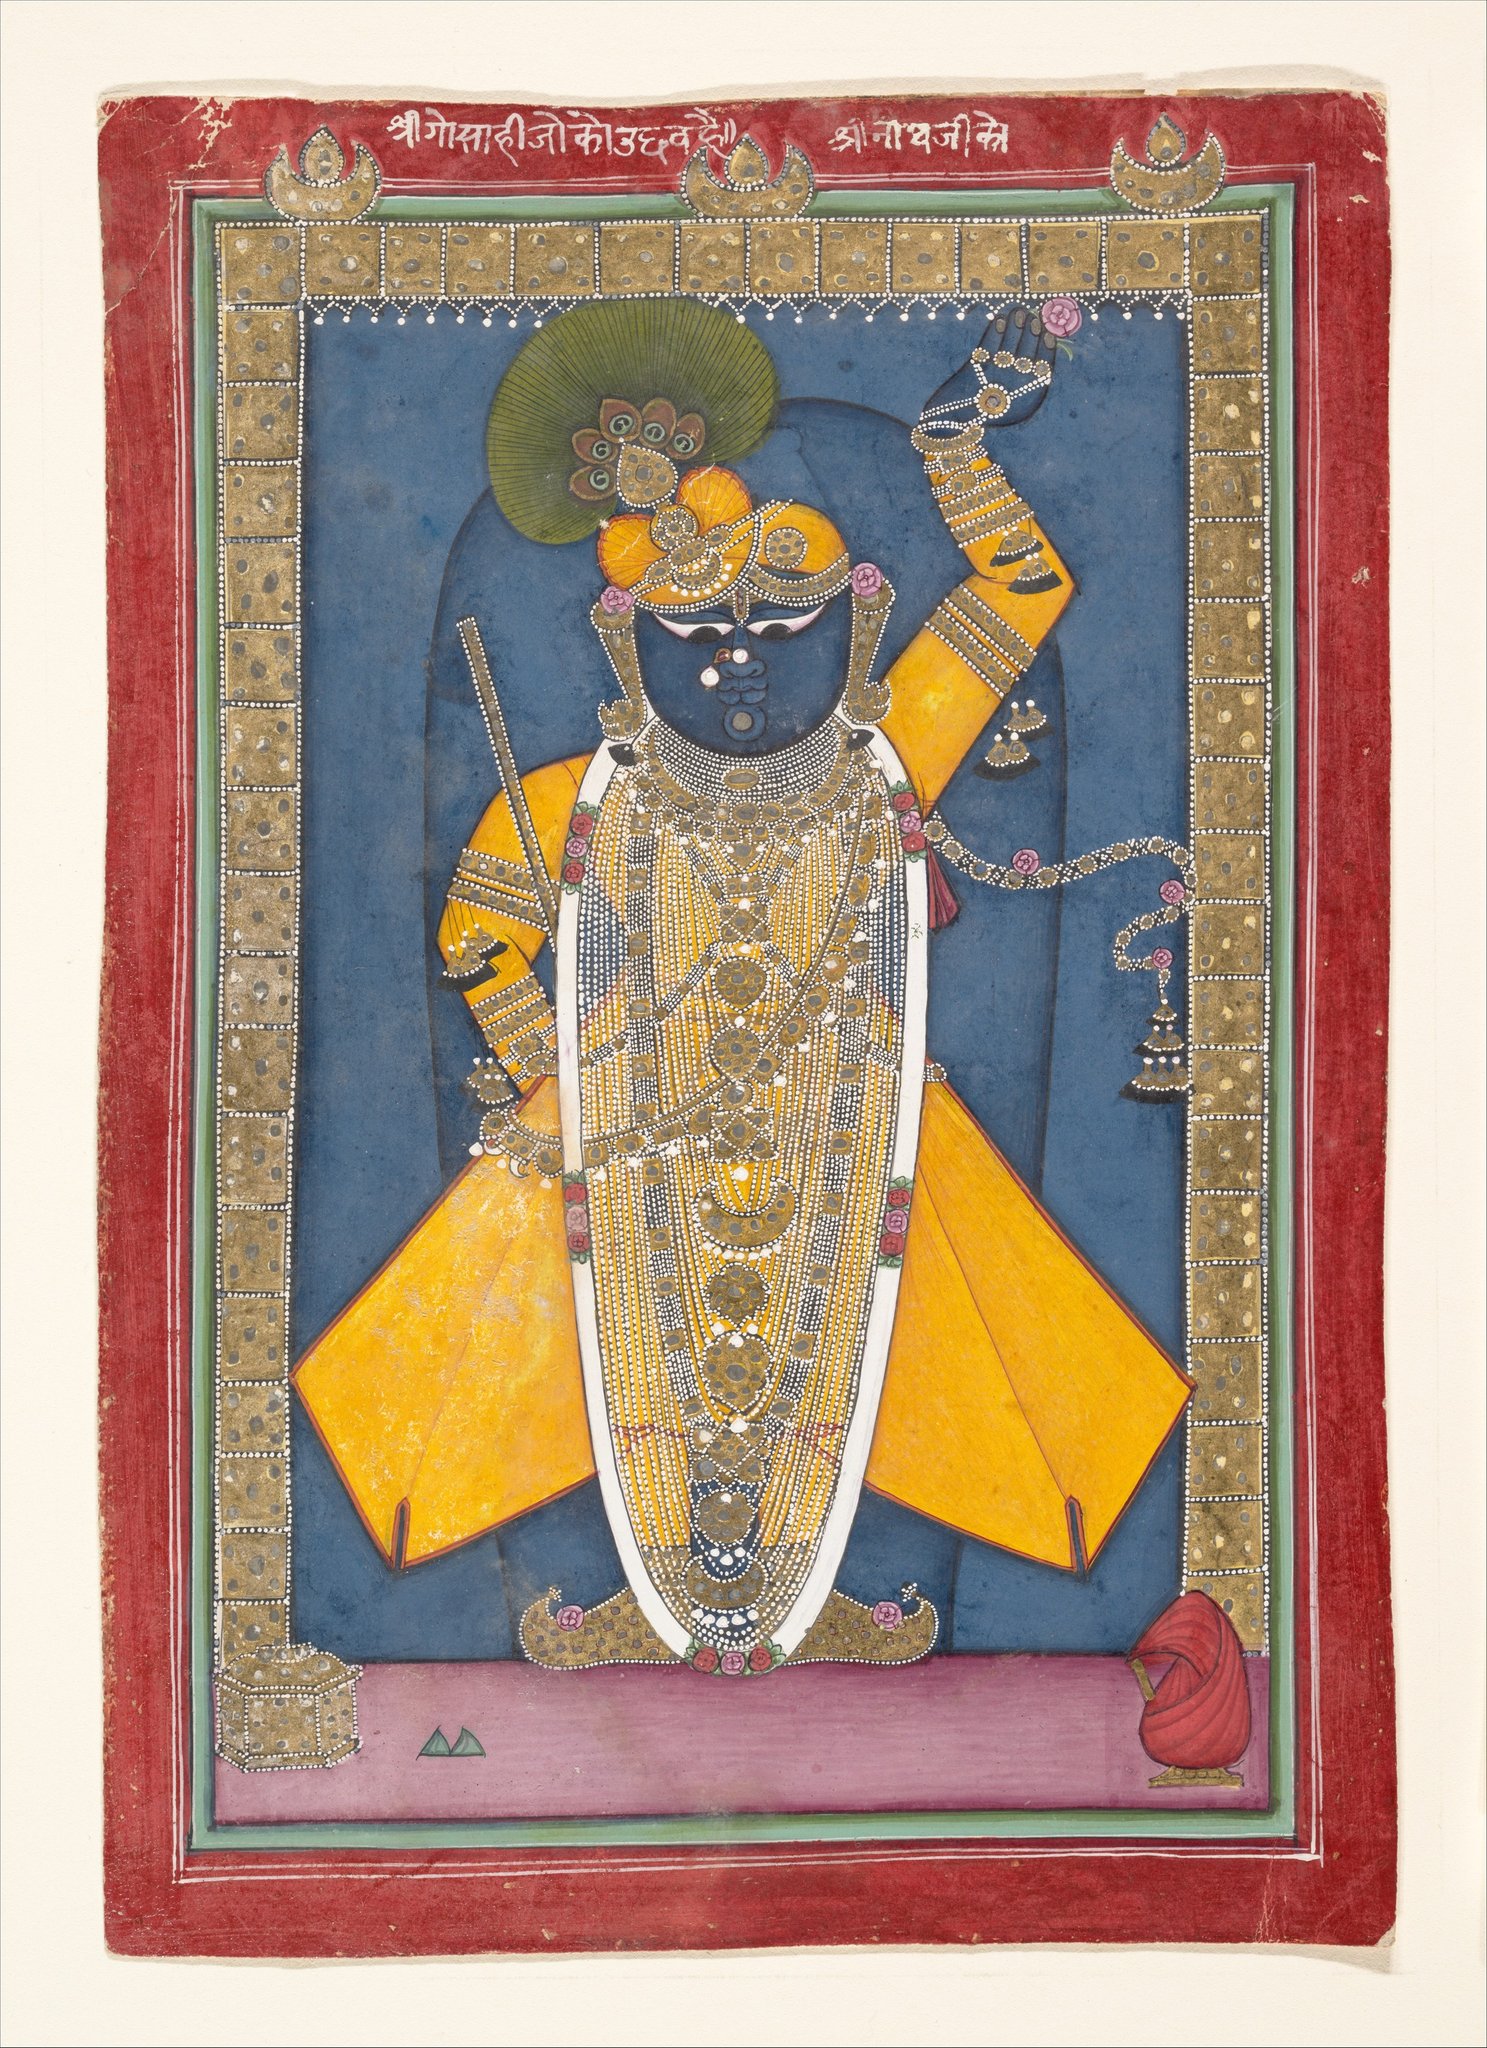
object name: painting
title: Krishna in the Form of Shri Nathji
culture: indian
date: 1840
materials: gold, paper, watercolor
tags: krishna,hinduism